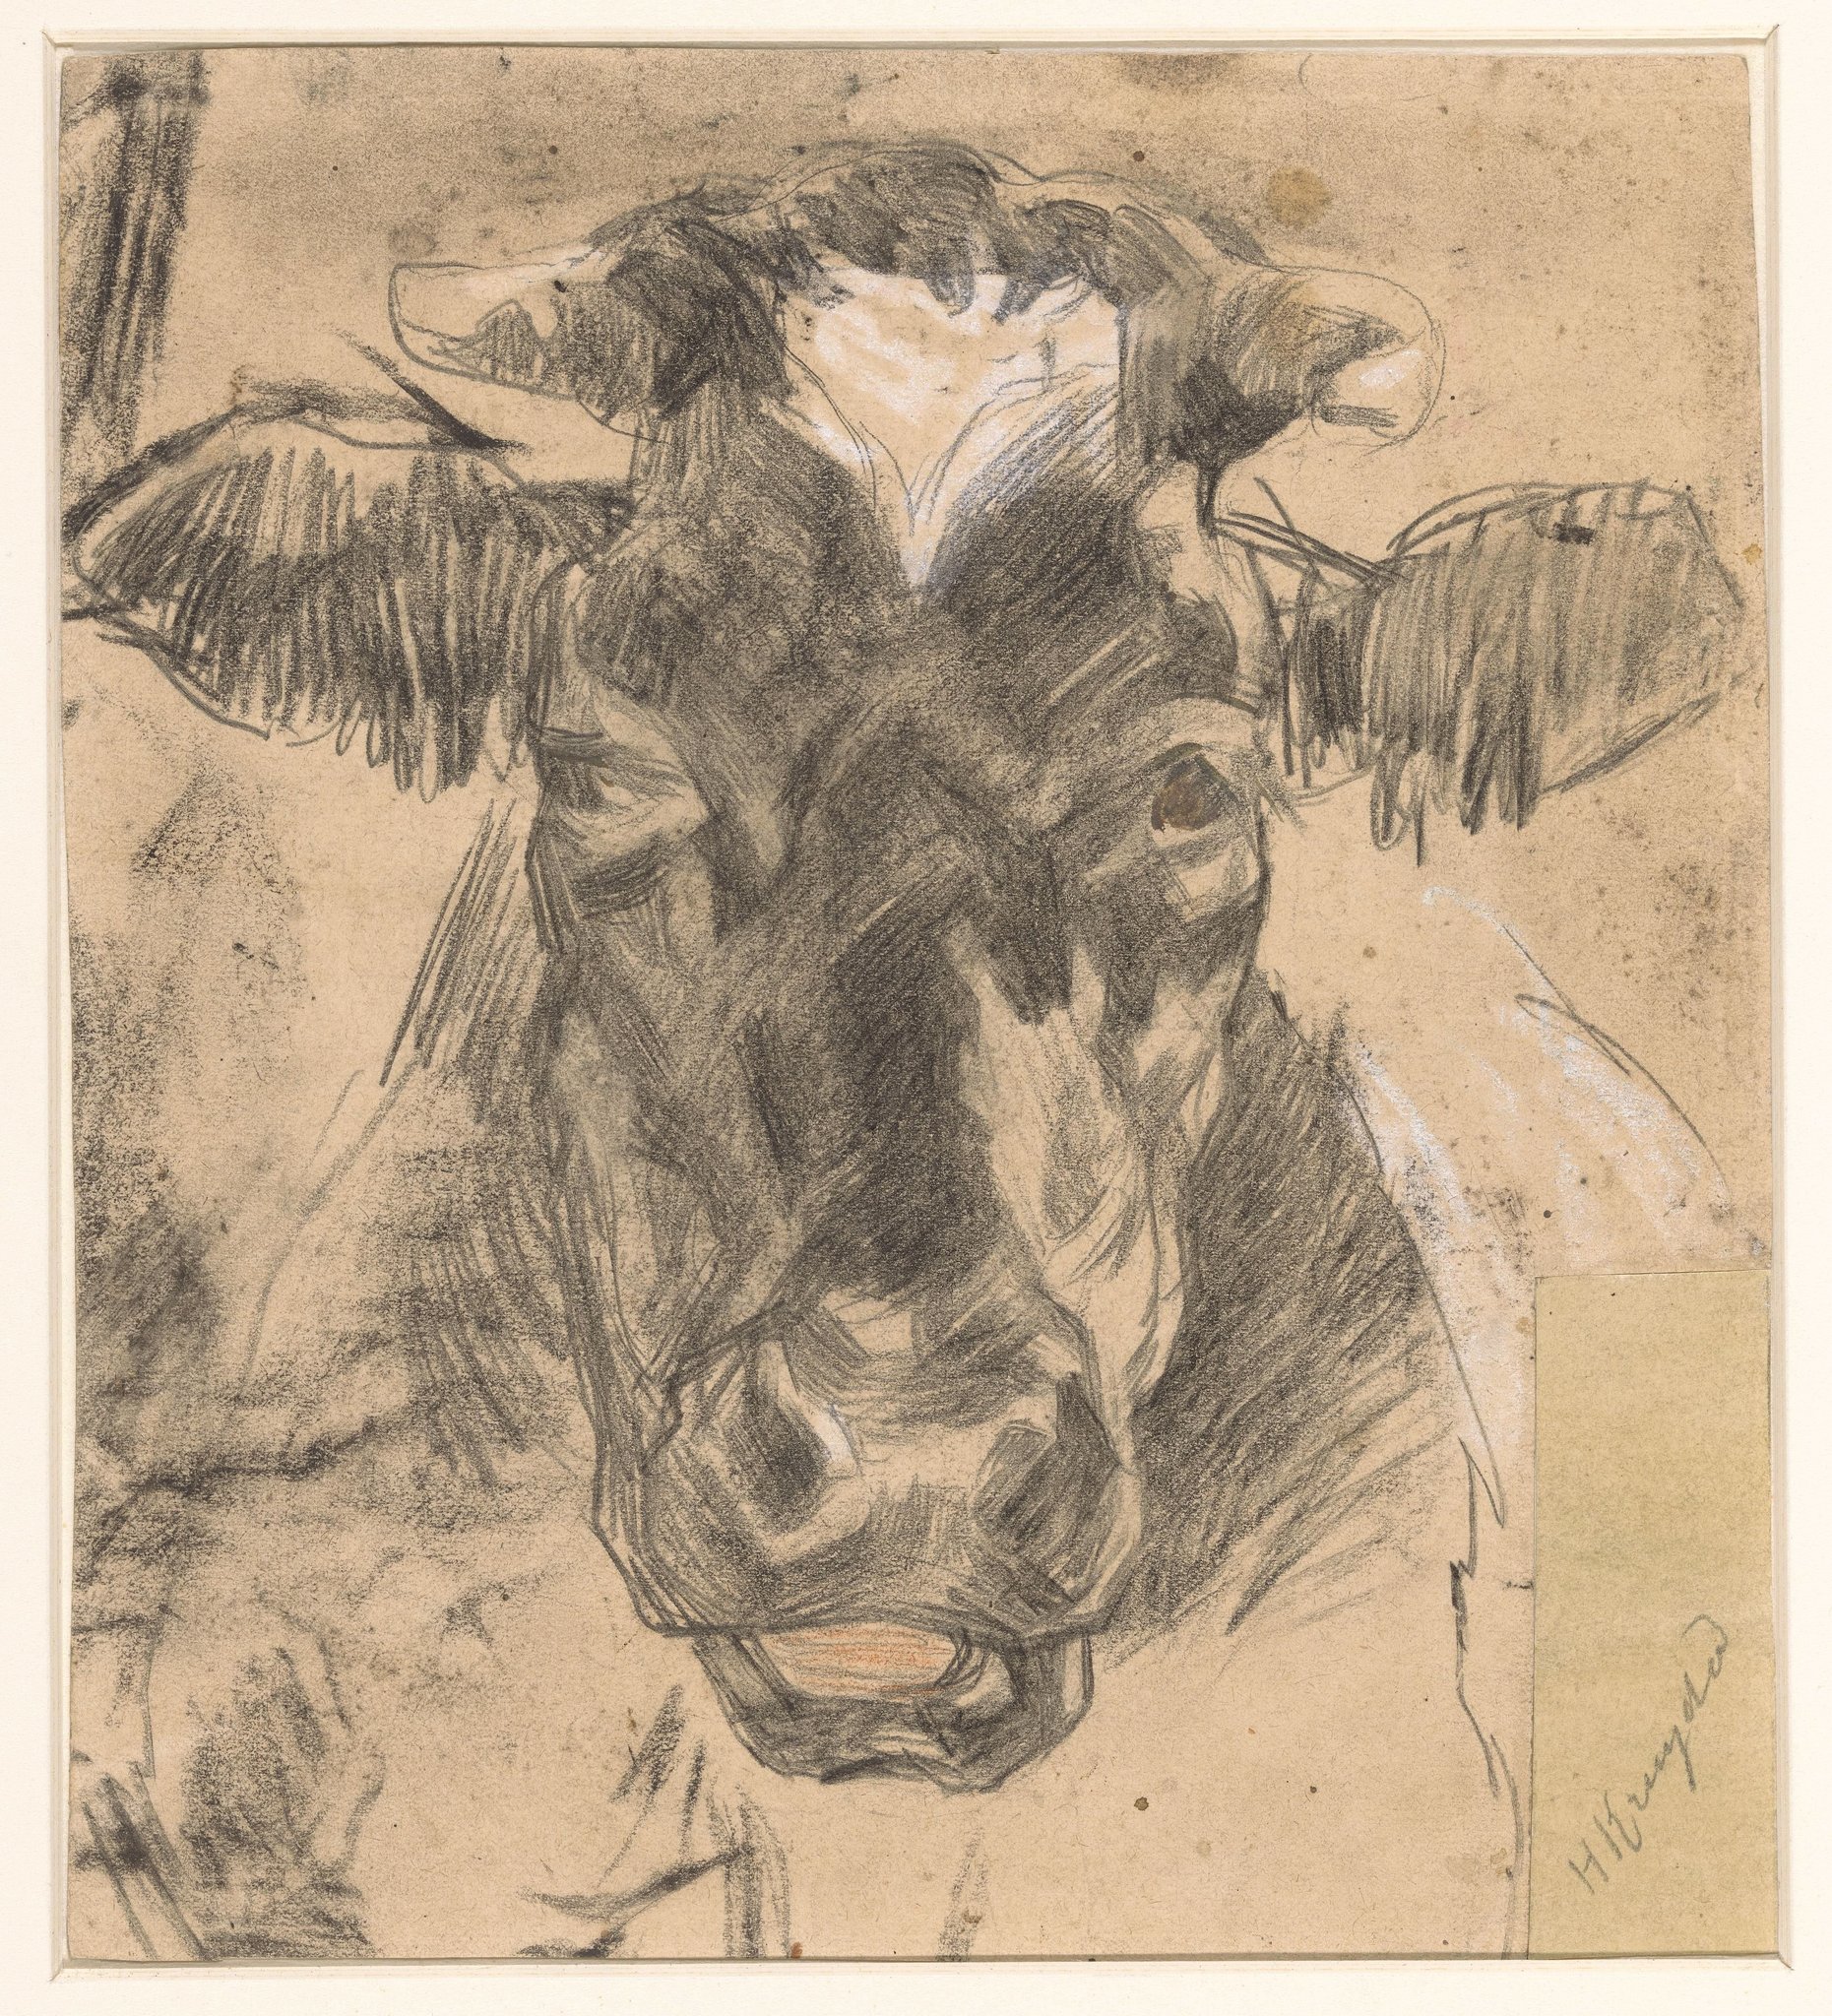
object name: drawing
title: Kop van een koe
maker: herman kruyder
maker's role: draughtsman, print maker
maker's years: 1881-1935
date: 1891-1935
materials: chalk, paper, pencil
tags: cow